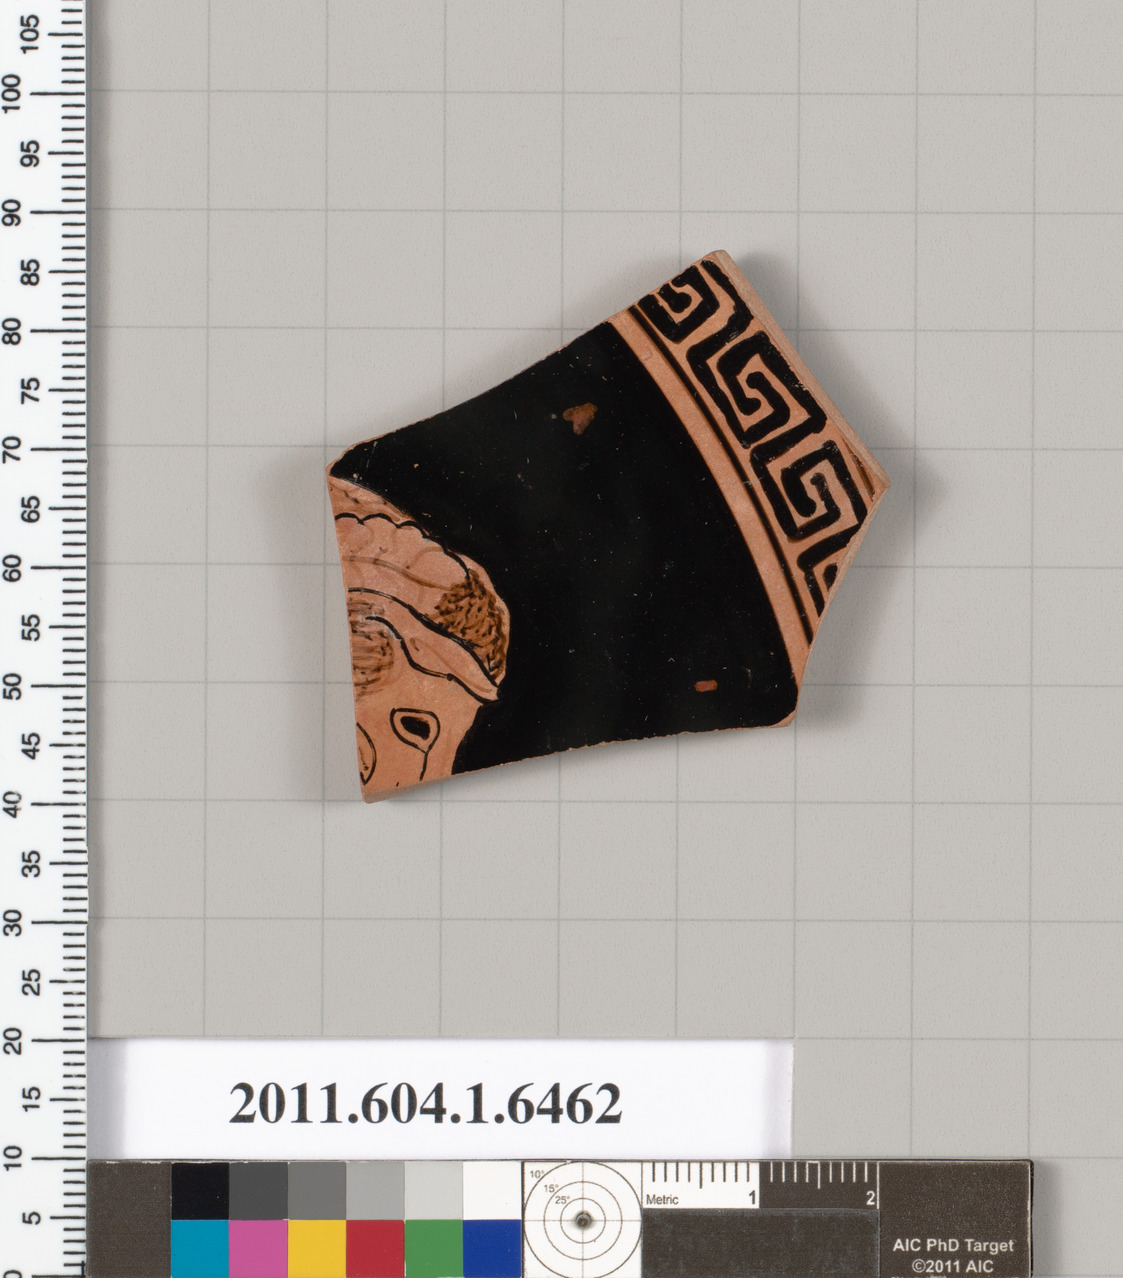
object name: kylix fragment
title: Terracotta fragment of a kylix (drinking cup)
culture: greek, attic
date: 490-480 BCE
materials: terracotta